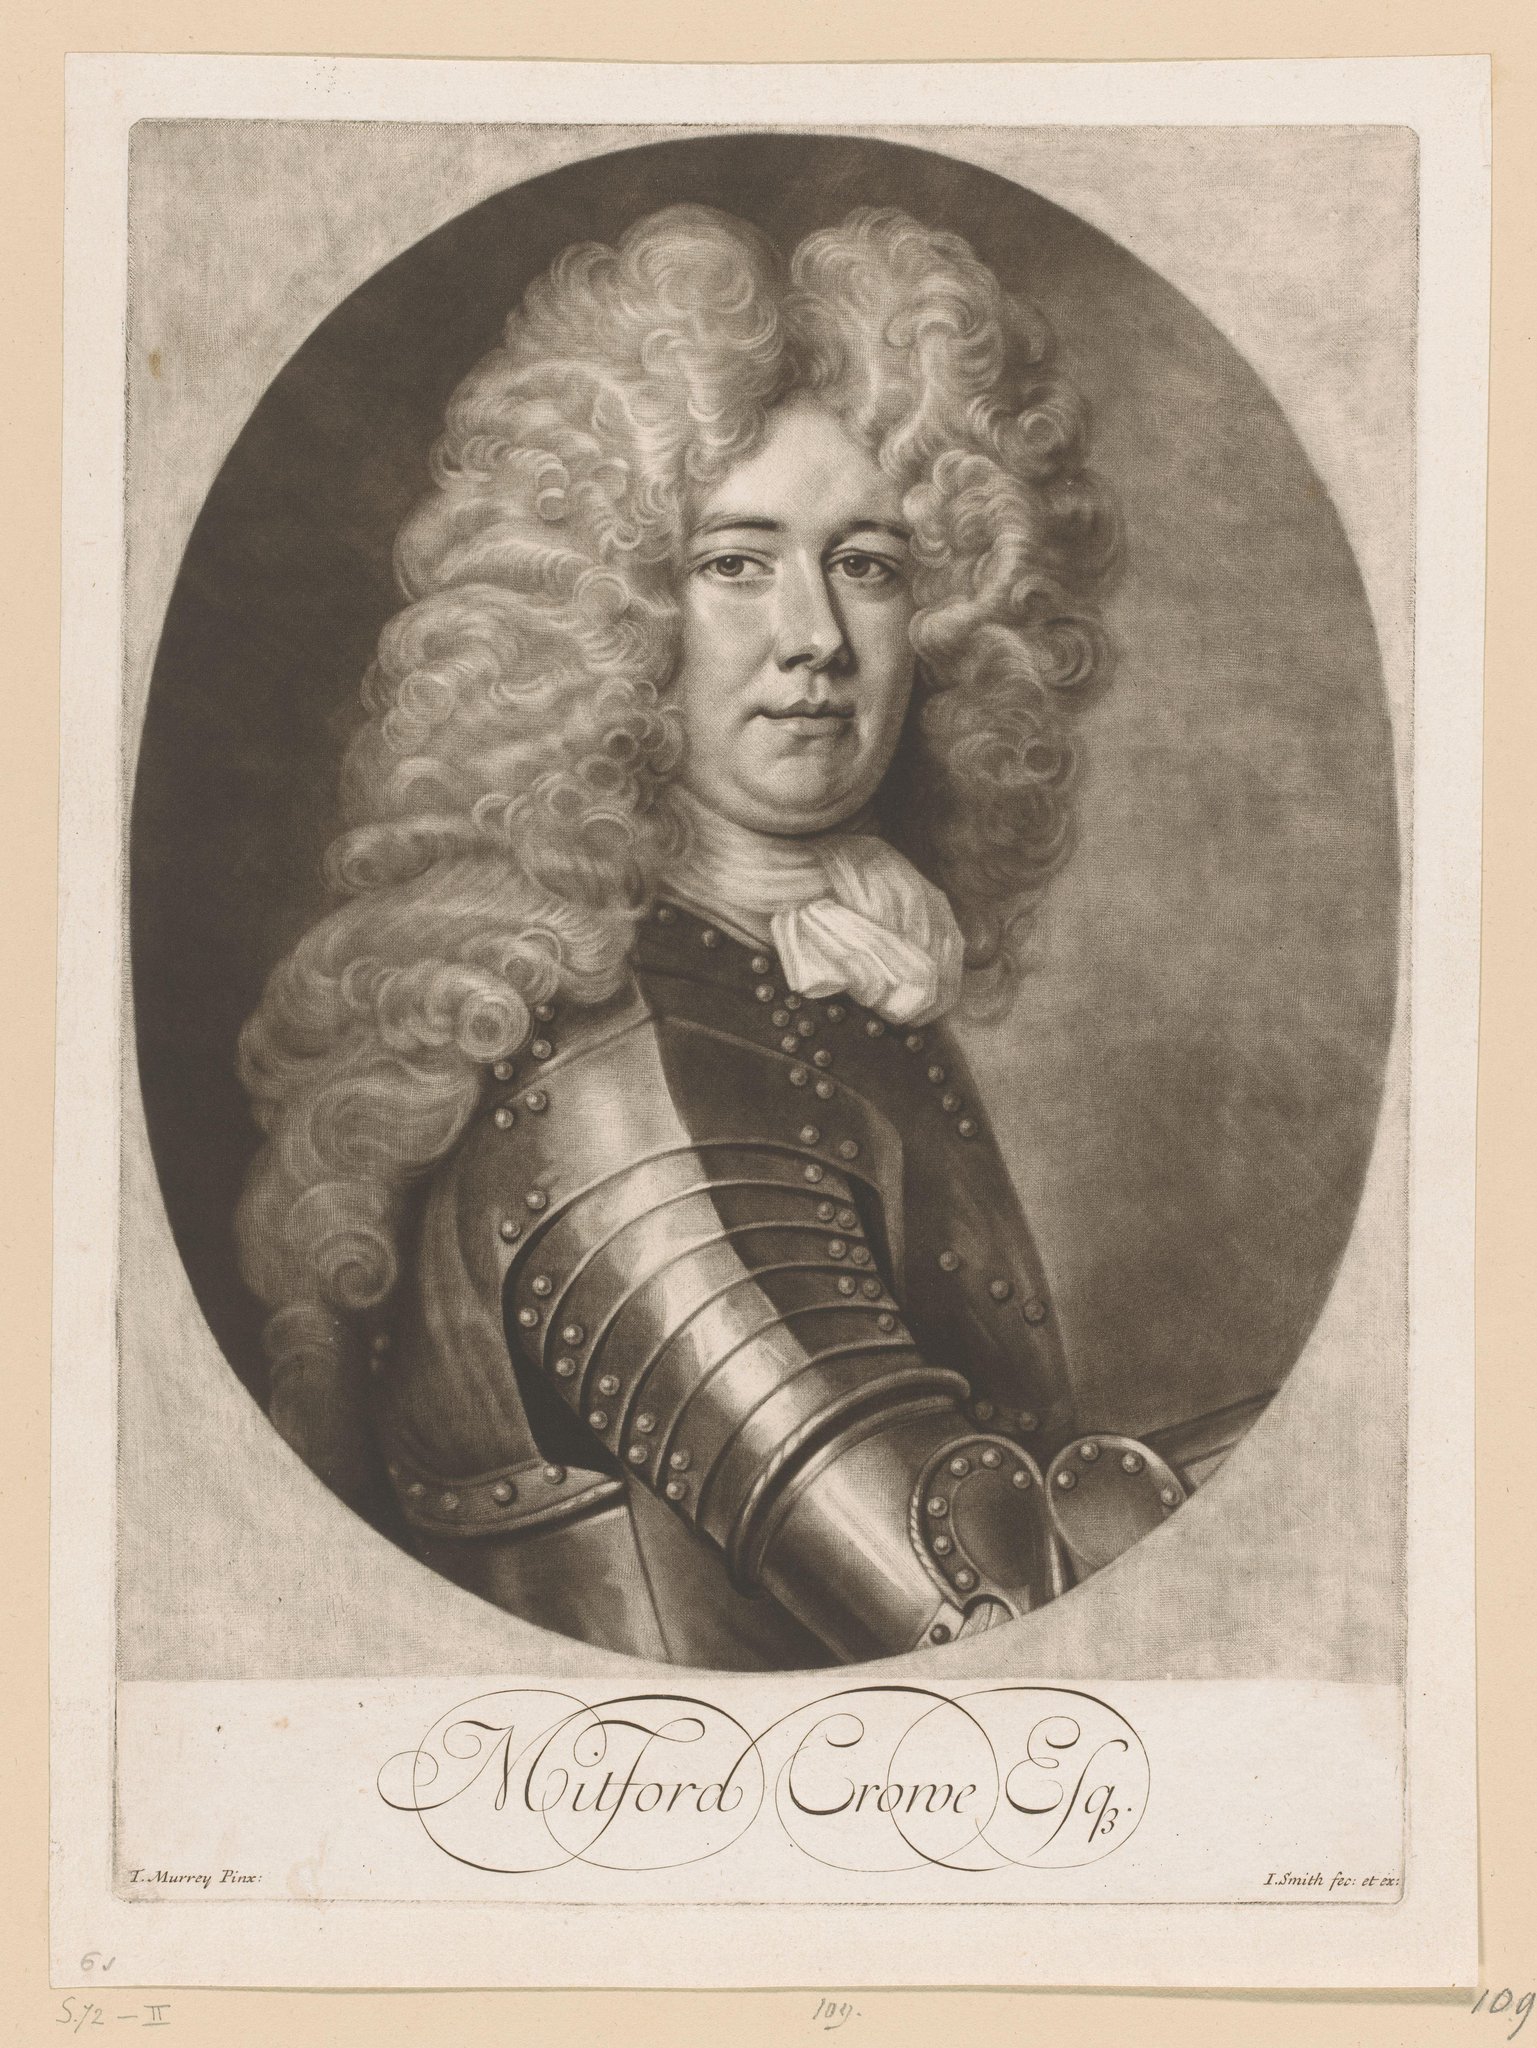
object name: print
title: Portret van Mitford Crowe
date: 1679-1742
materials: paper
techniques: mezzotint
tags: politician, historical persons, politician, e.g. party leader, diplomacy, diplomat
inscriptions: collector's mark: Lugt 240